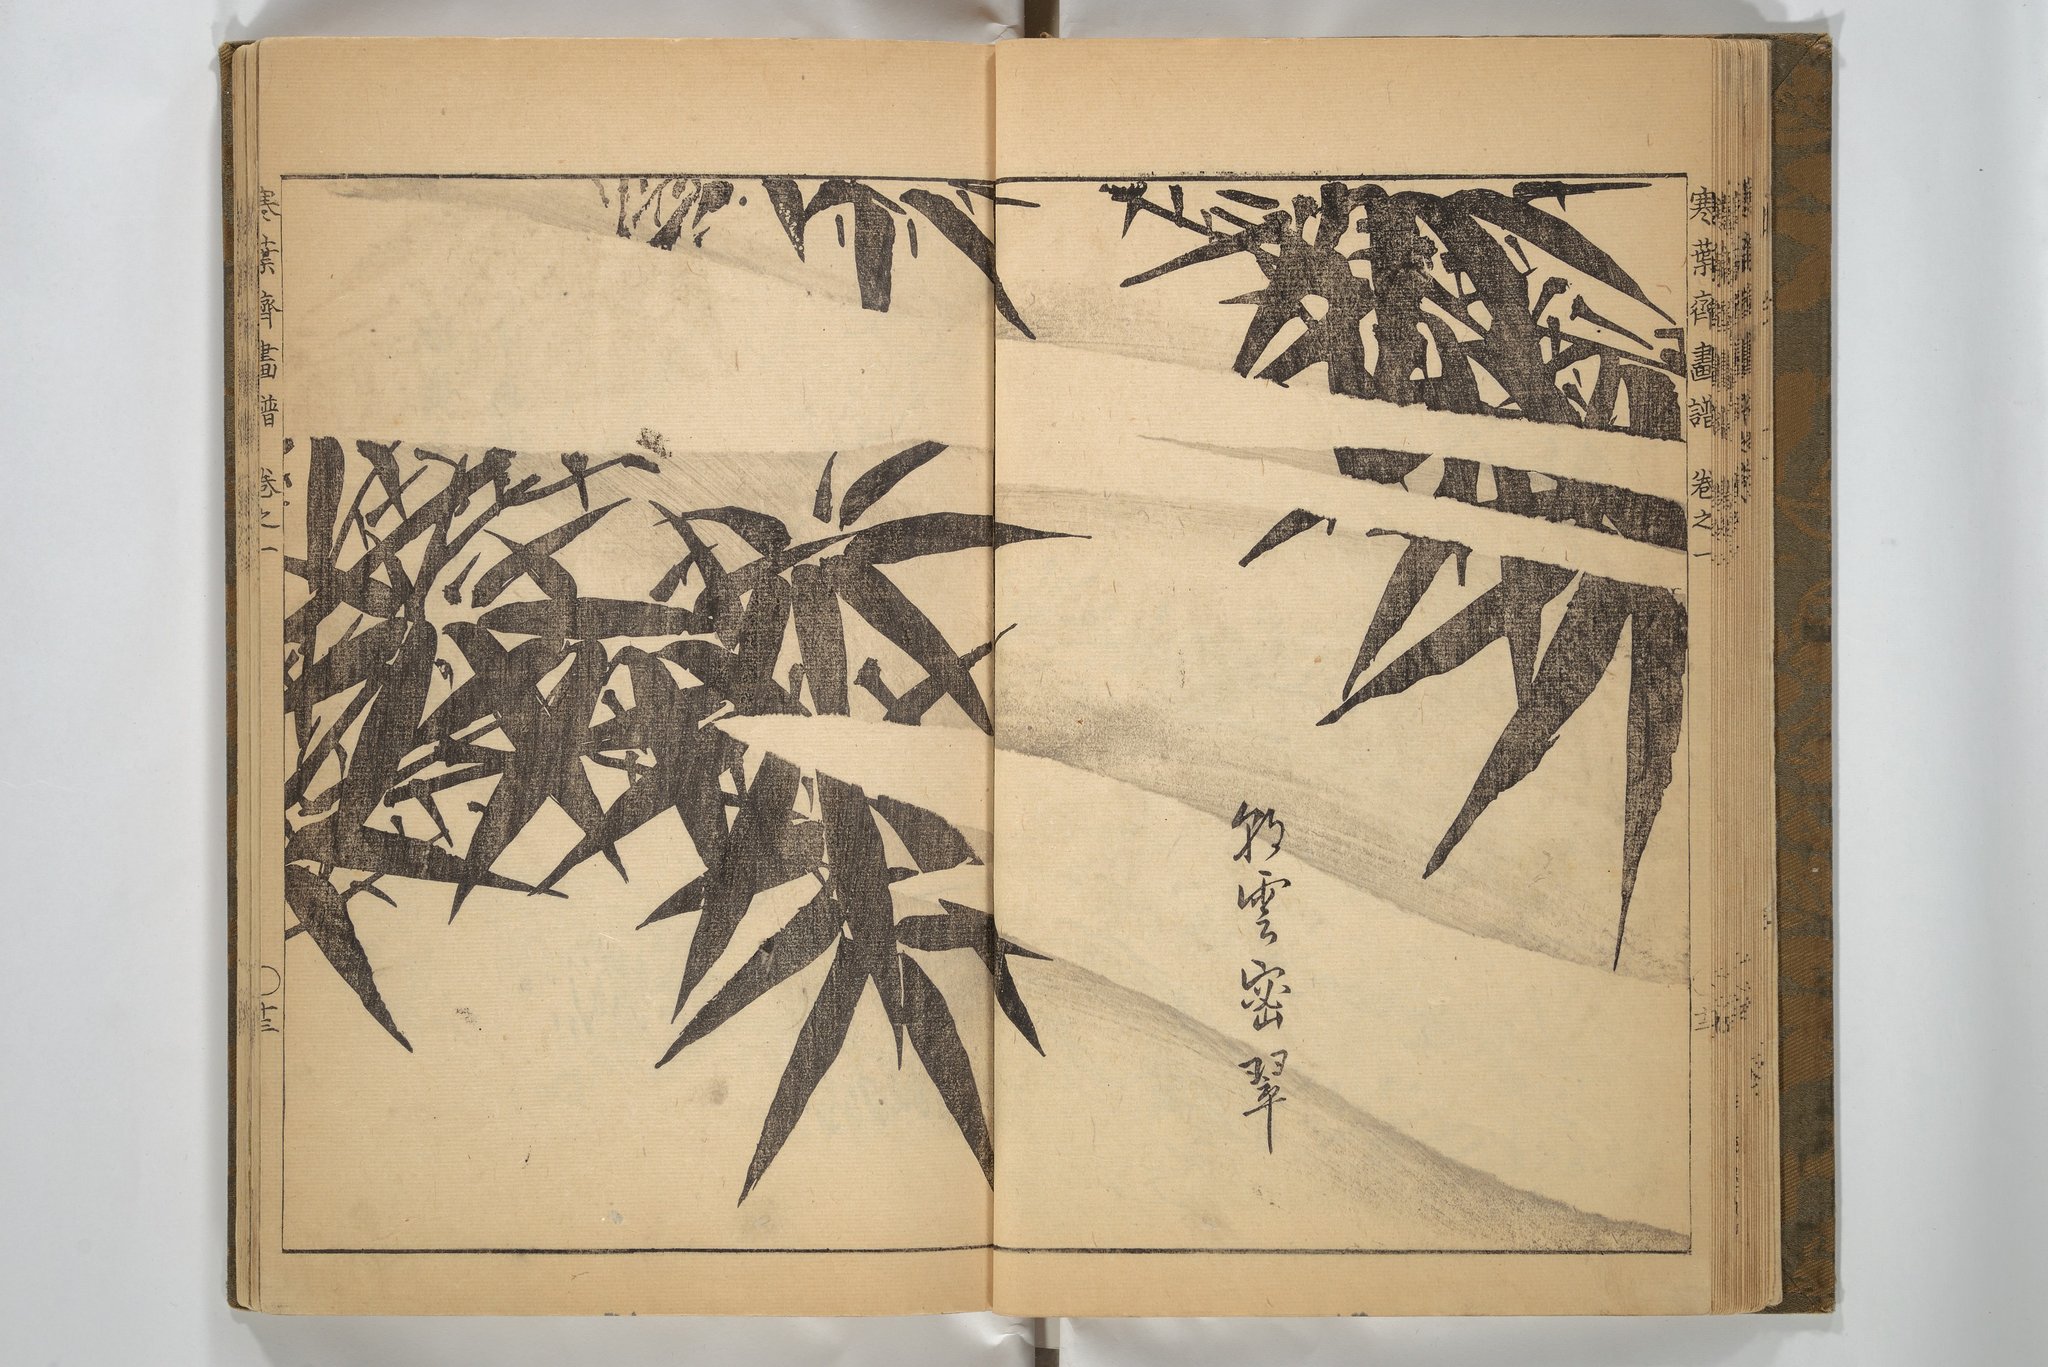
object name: illustrated book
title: Kan'yōsai Picture Album (Kan'yōsai gafu) 寒葉斎画譜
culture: japanese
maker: kan'yōsai 寒葉斎 (tatebe ayatari 建部綾足)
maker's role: artist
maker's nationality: japanese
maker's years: 1719-1774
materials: ink, paper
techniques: woodblock print